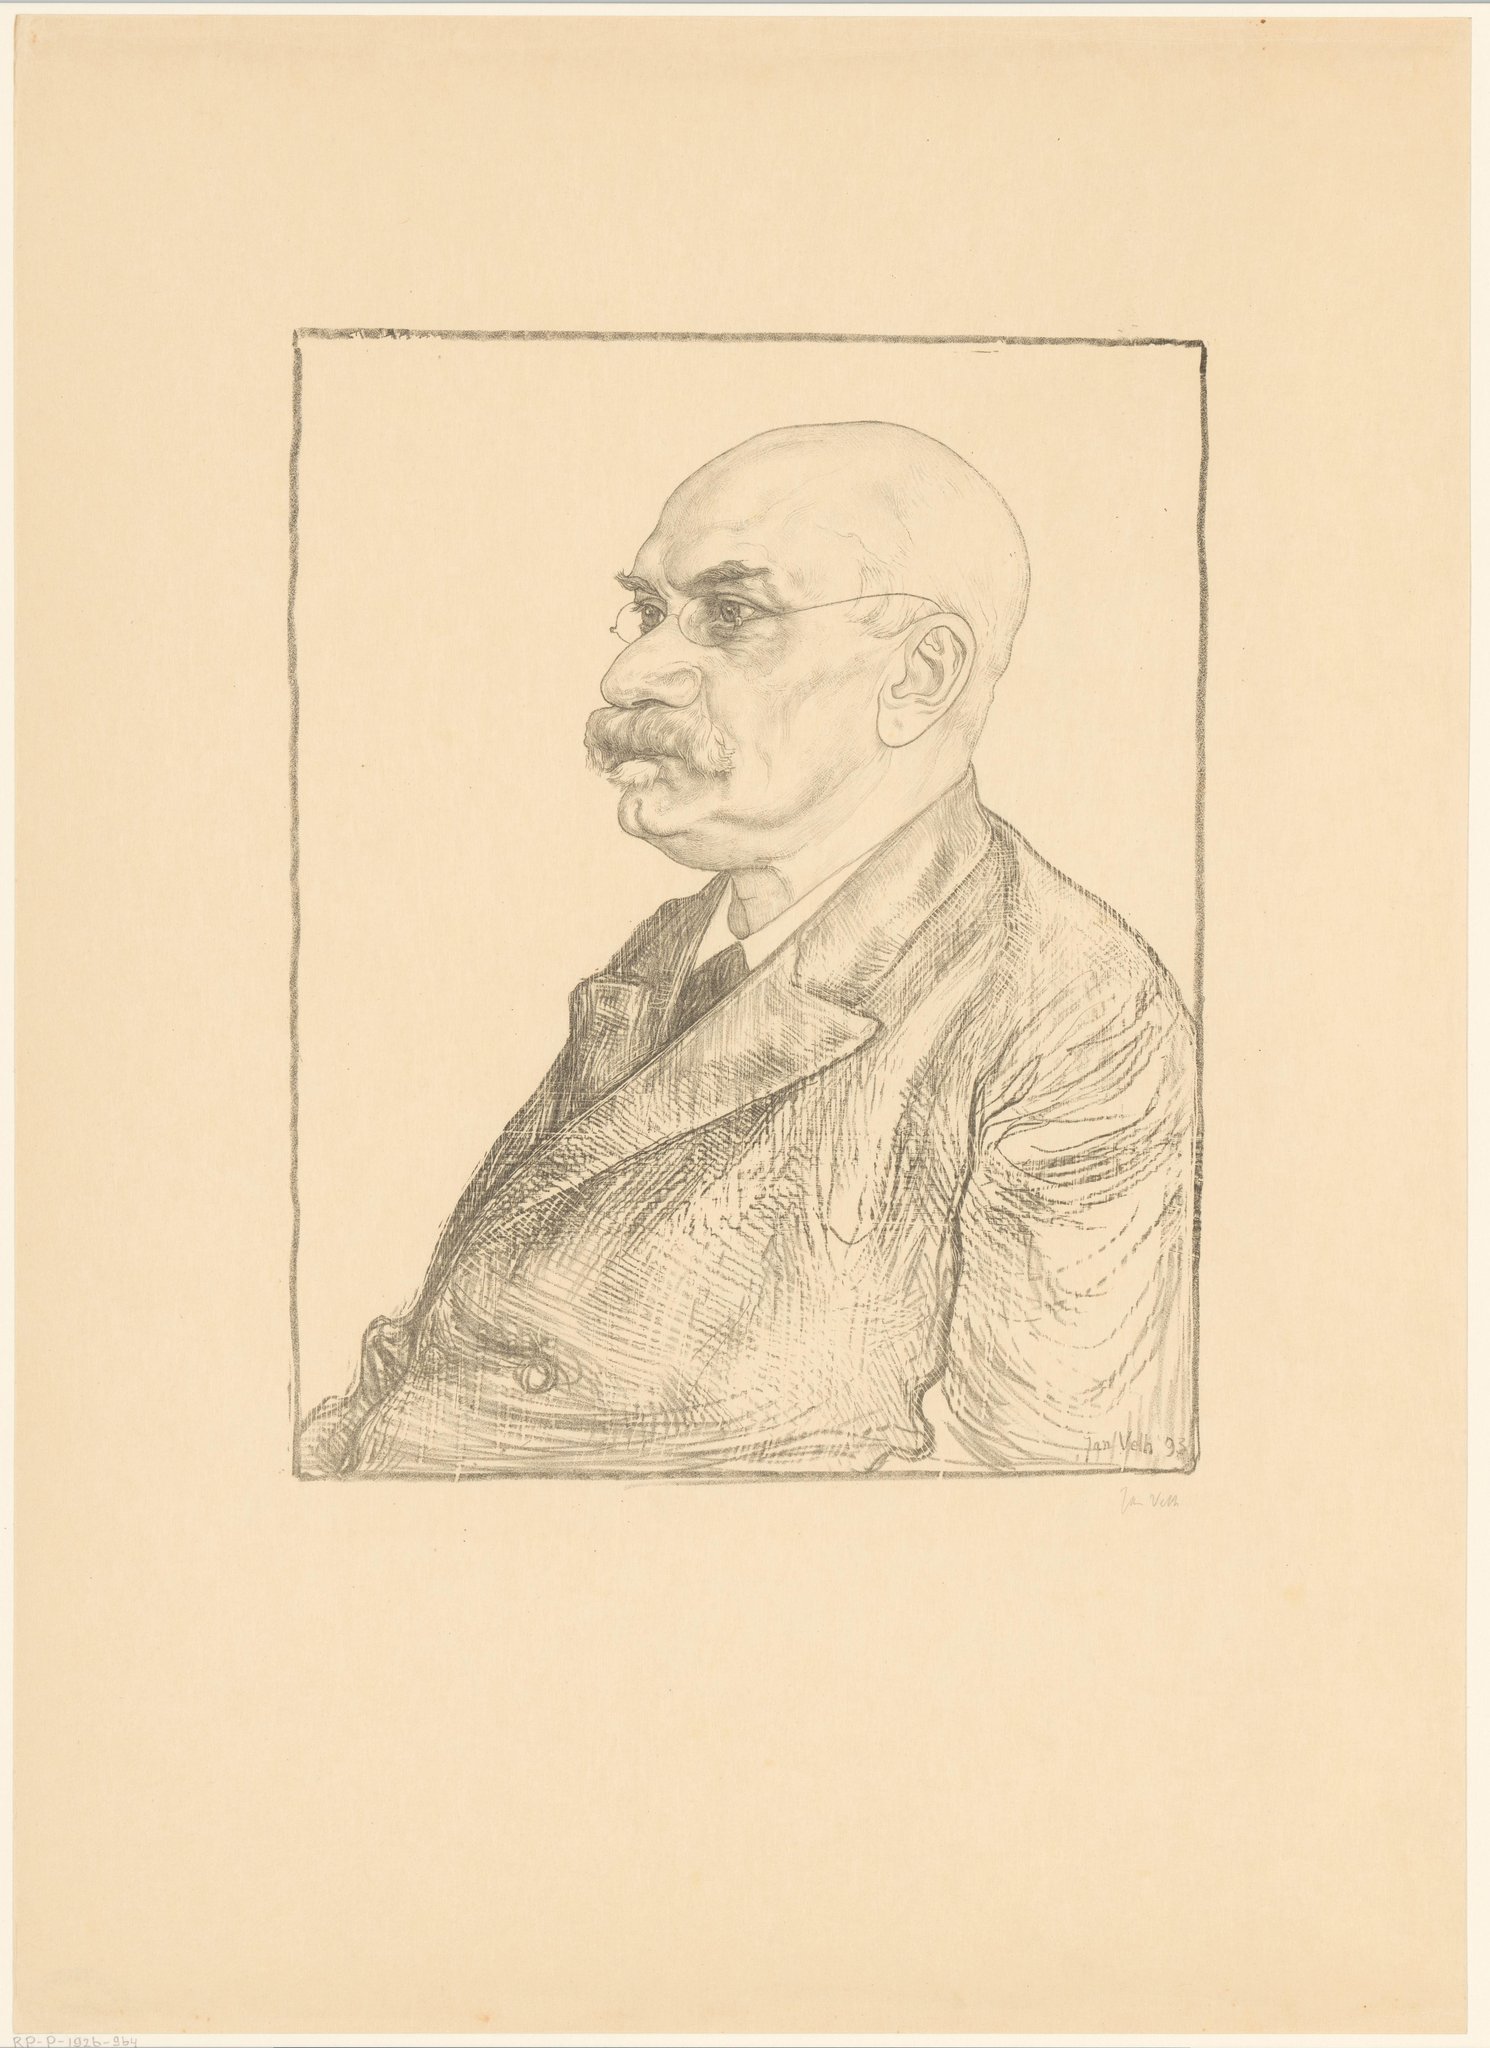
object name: print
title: Bekende tijdgenooten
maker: jan veth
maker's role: designer, draughtsman, painter, print maker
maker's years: 1864-1925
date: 1893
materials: paper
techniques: lithograph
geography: netherlands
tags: historical persons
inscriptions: collector's mark: Lugt 2228, inscription: ‘Jan Veth’, collector's mark: ‘H.G. Samson Amsterdam’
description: Deze prent werd uitgegeven als bijvoegsel van De Amsterdammer op 29 oktober 1893.